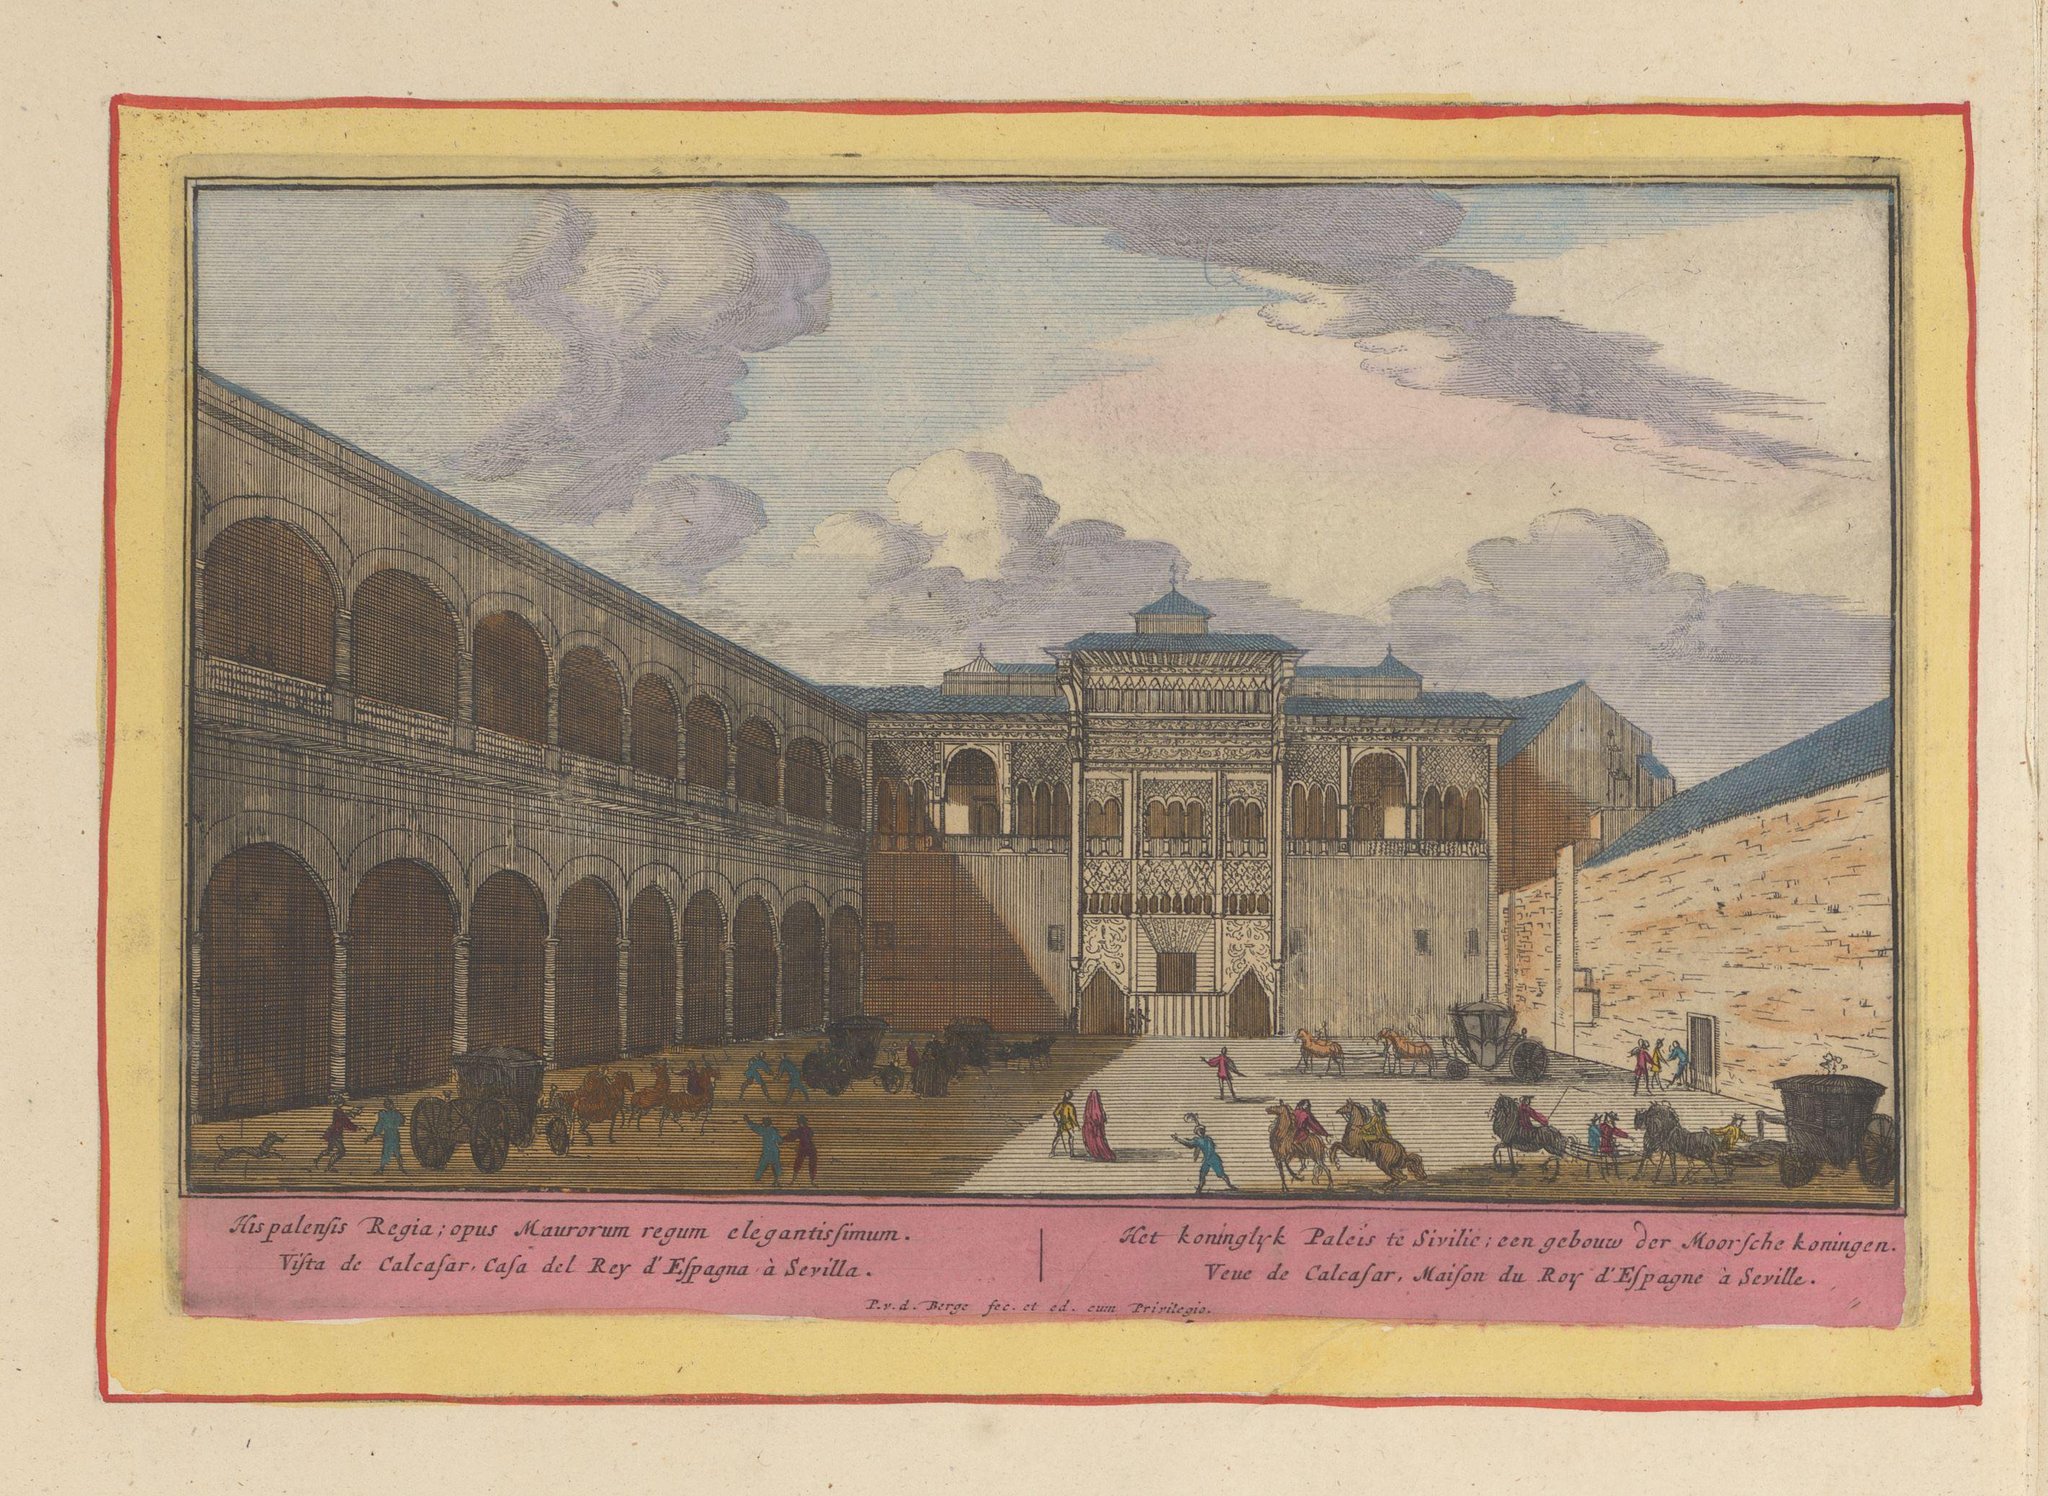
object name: print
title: Gezicht op een binnenplaats van het Real Alcázar te Sevilla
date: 1694-1737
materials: paper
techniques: etching, hand coloring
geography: amsterdam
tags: palace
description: Prent uit: Theatrum Hispaniæ, exhibens regni urbes, villas ac viridaria magis illustria. Het aanmerkelykste en voortreffelykste in Spanjen (...). Amsterdam: Pieter van den Berge, ca. 1694-1737.